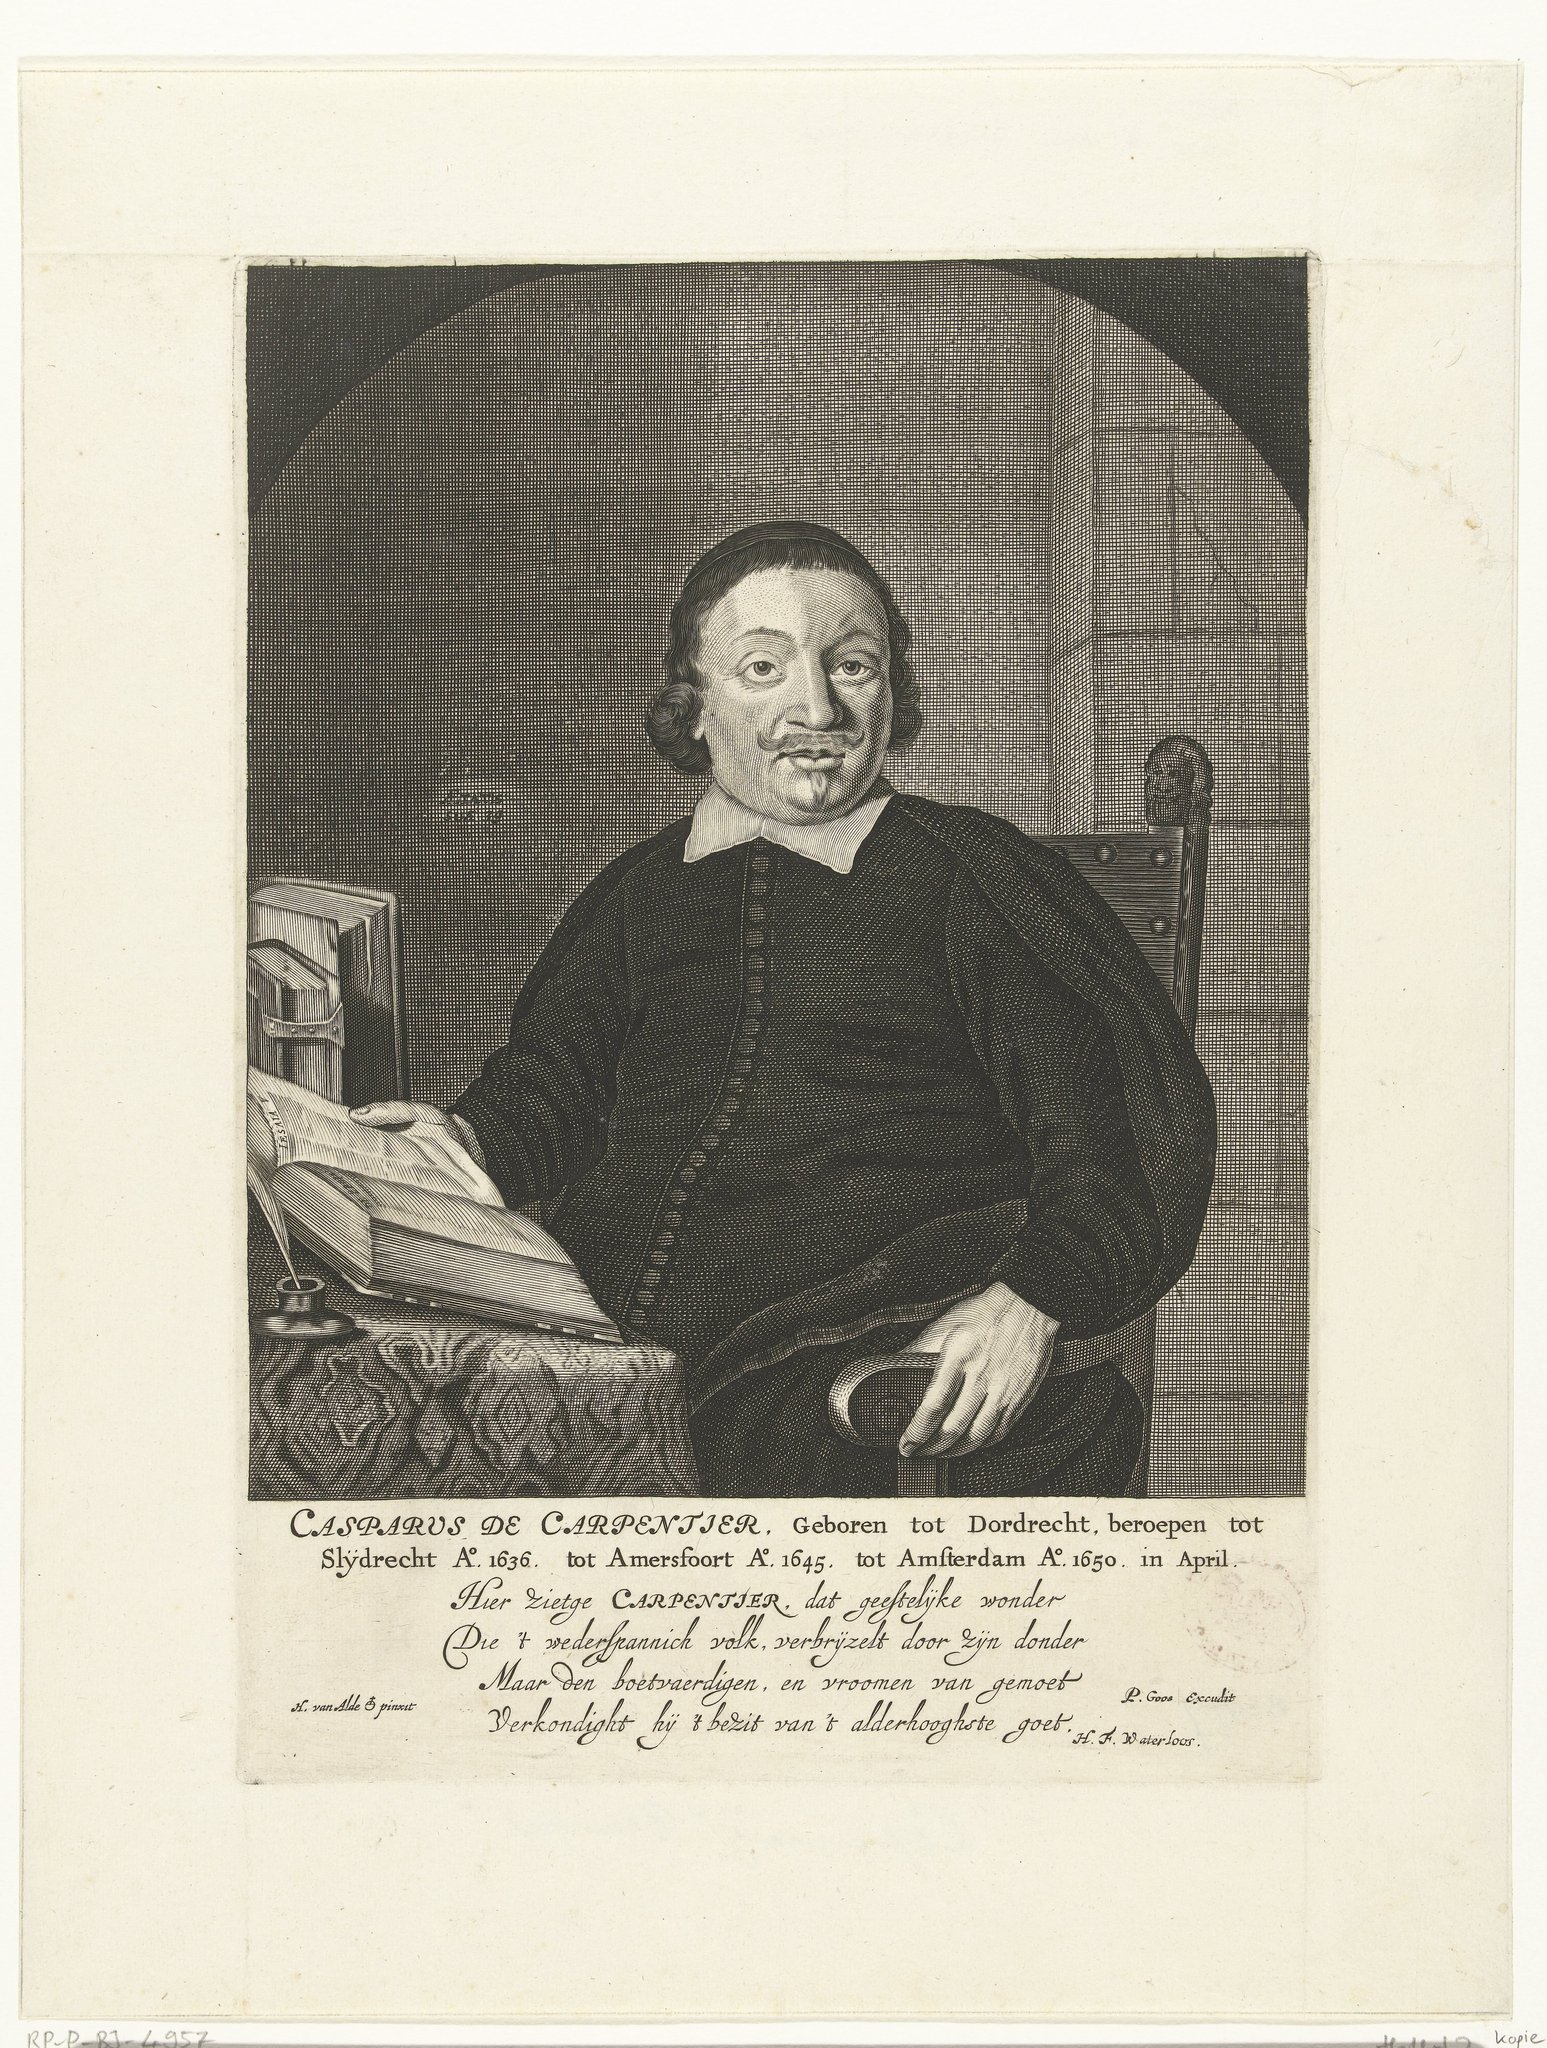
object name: print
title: Portret van Casparus de Carpentier op 39-jarige leeftijd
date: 1657-1675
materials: paper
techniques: engraving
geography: amsterdam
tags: caspar de carpentier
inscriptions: collector's mark: Lugt 240